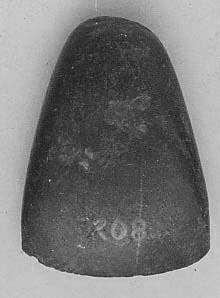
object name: hatchet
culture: french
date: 1902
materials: jade